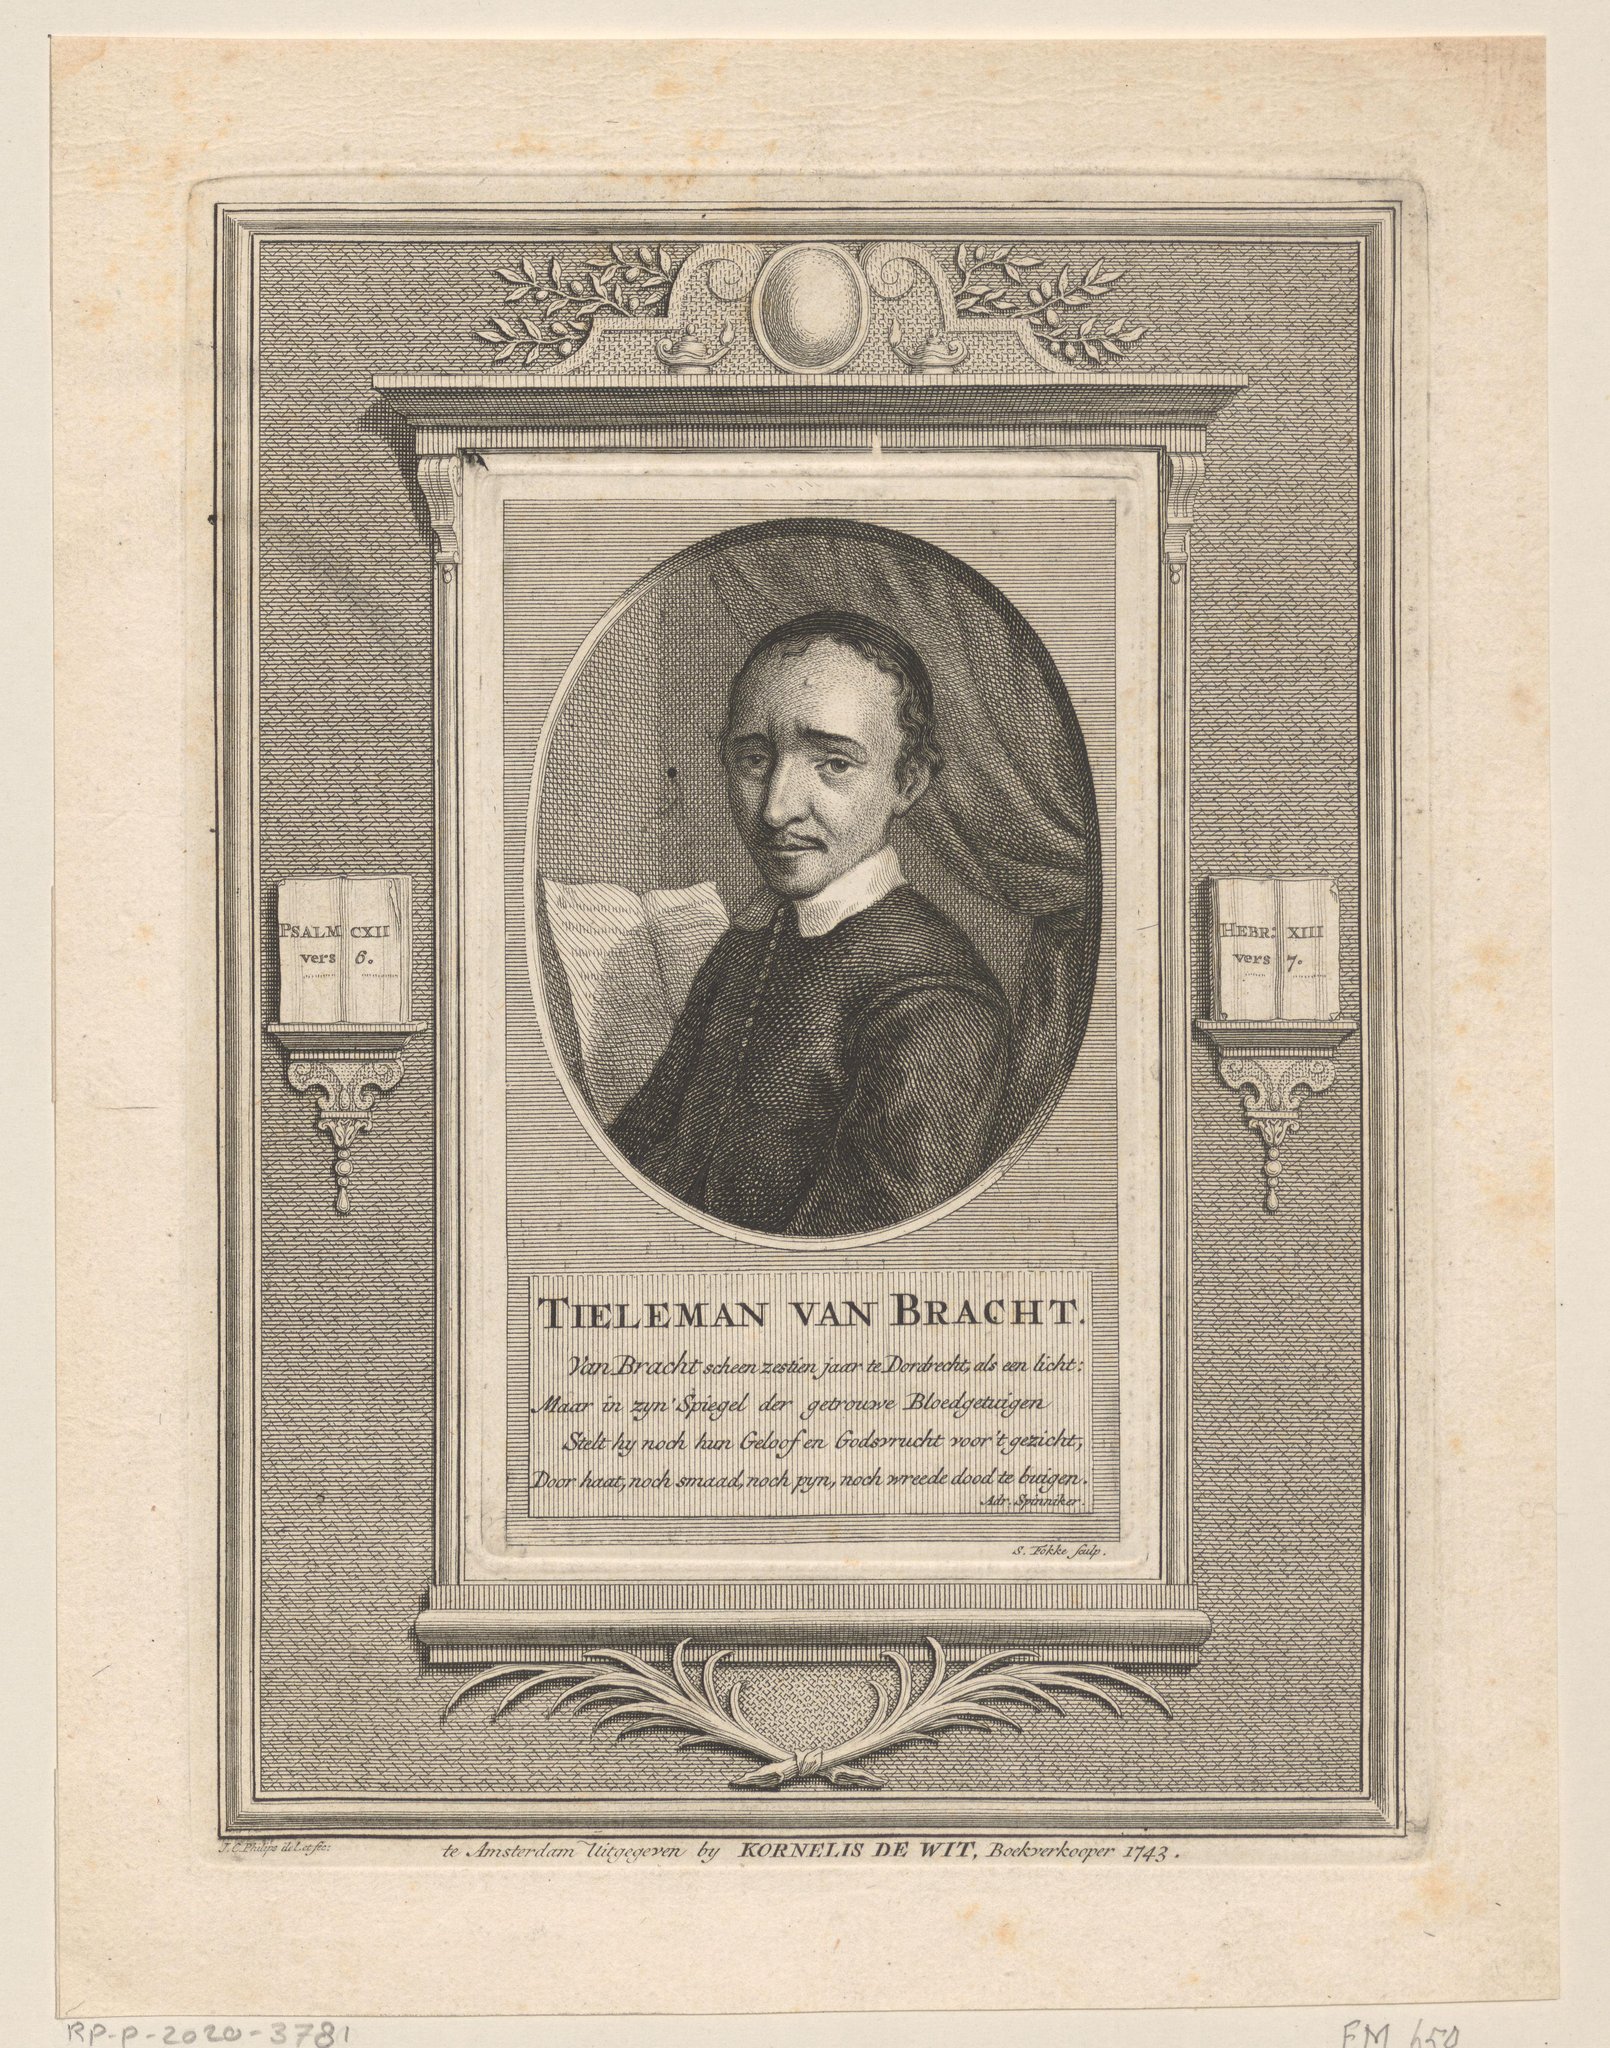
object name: print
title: Portret van Tieleman van Bracht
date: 1743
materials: paper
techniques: engraving, etching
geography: amsterdam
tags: dordrecht, historical persons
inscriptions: date